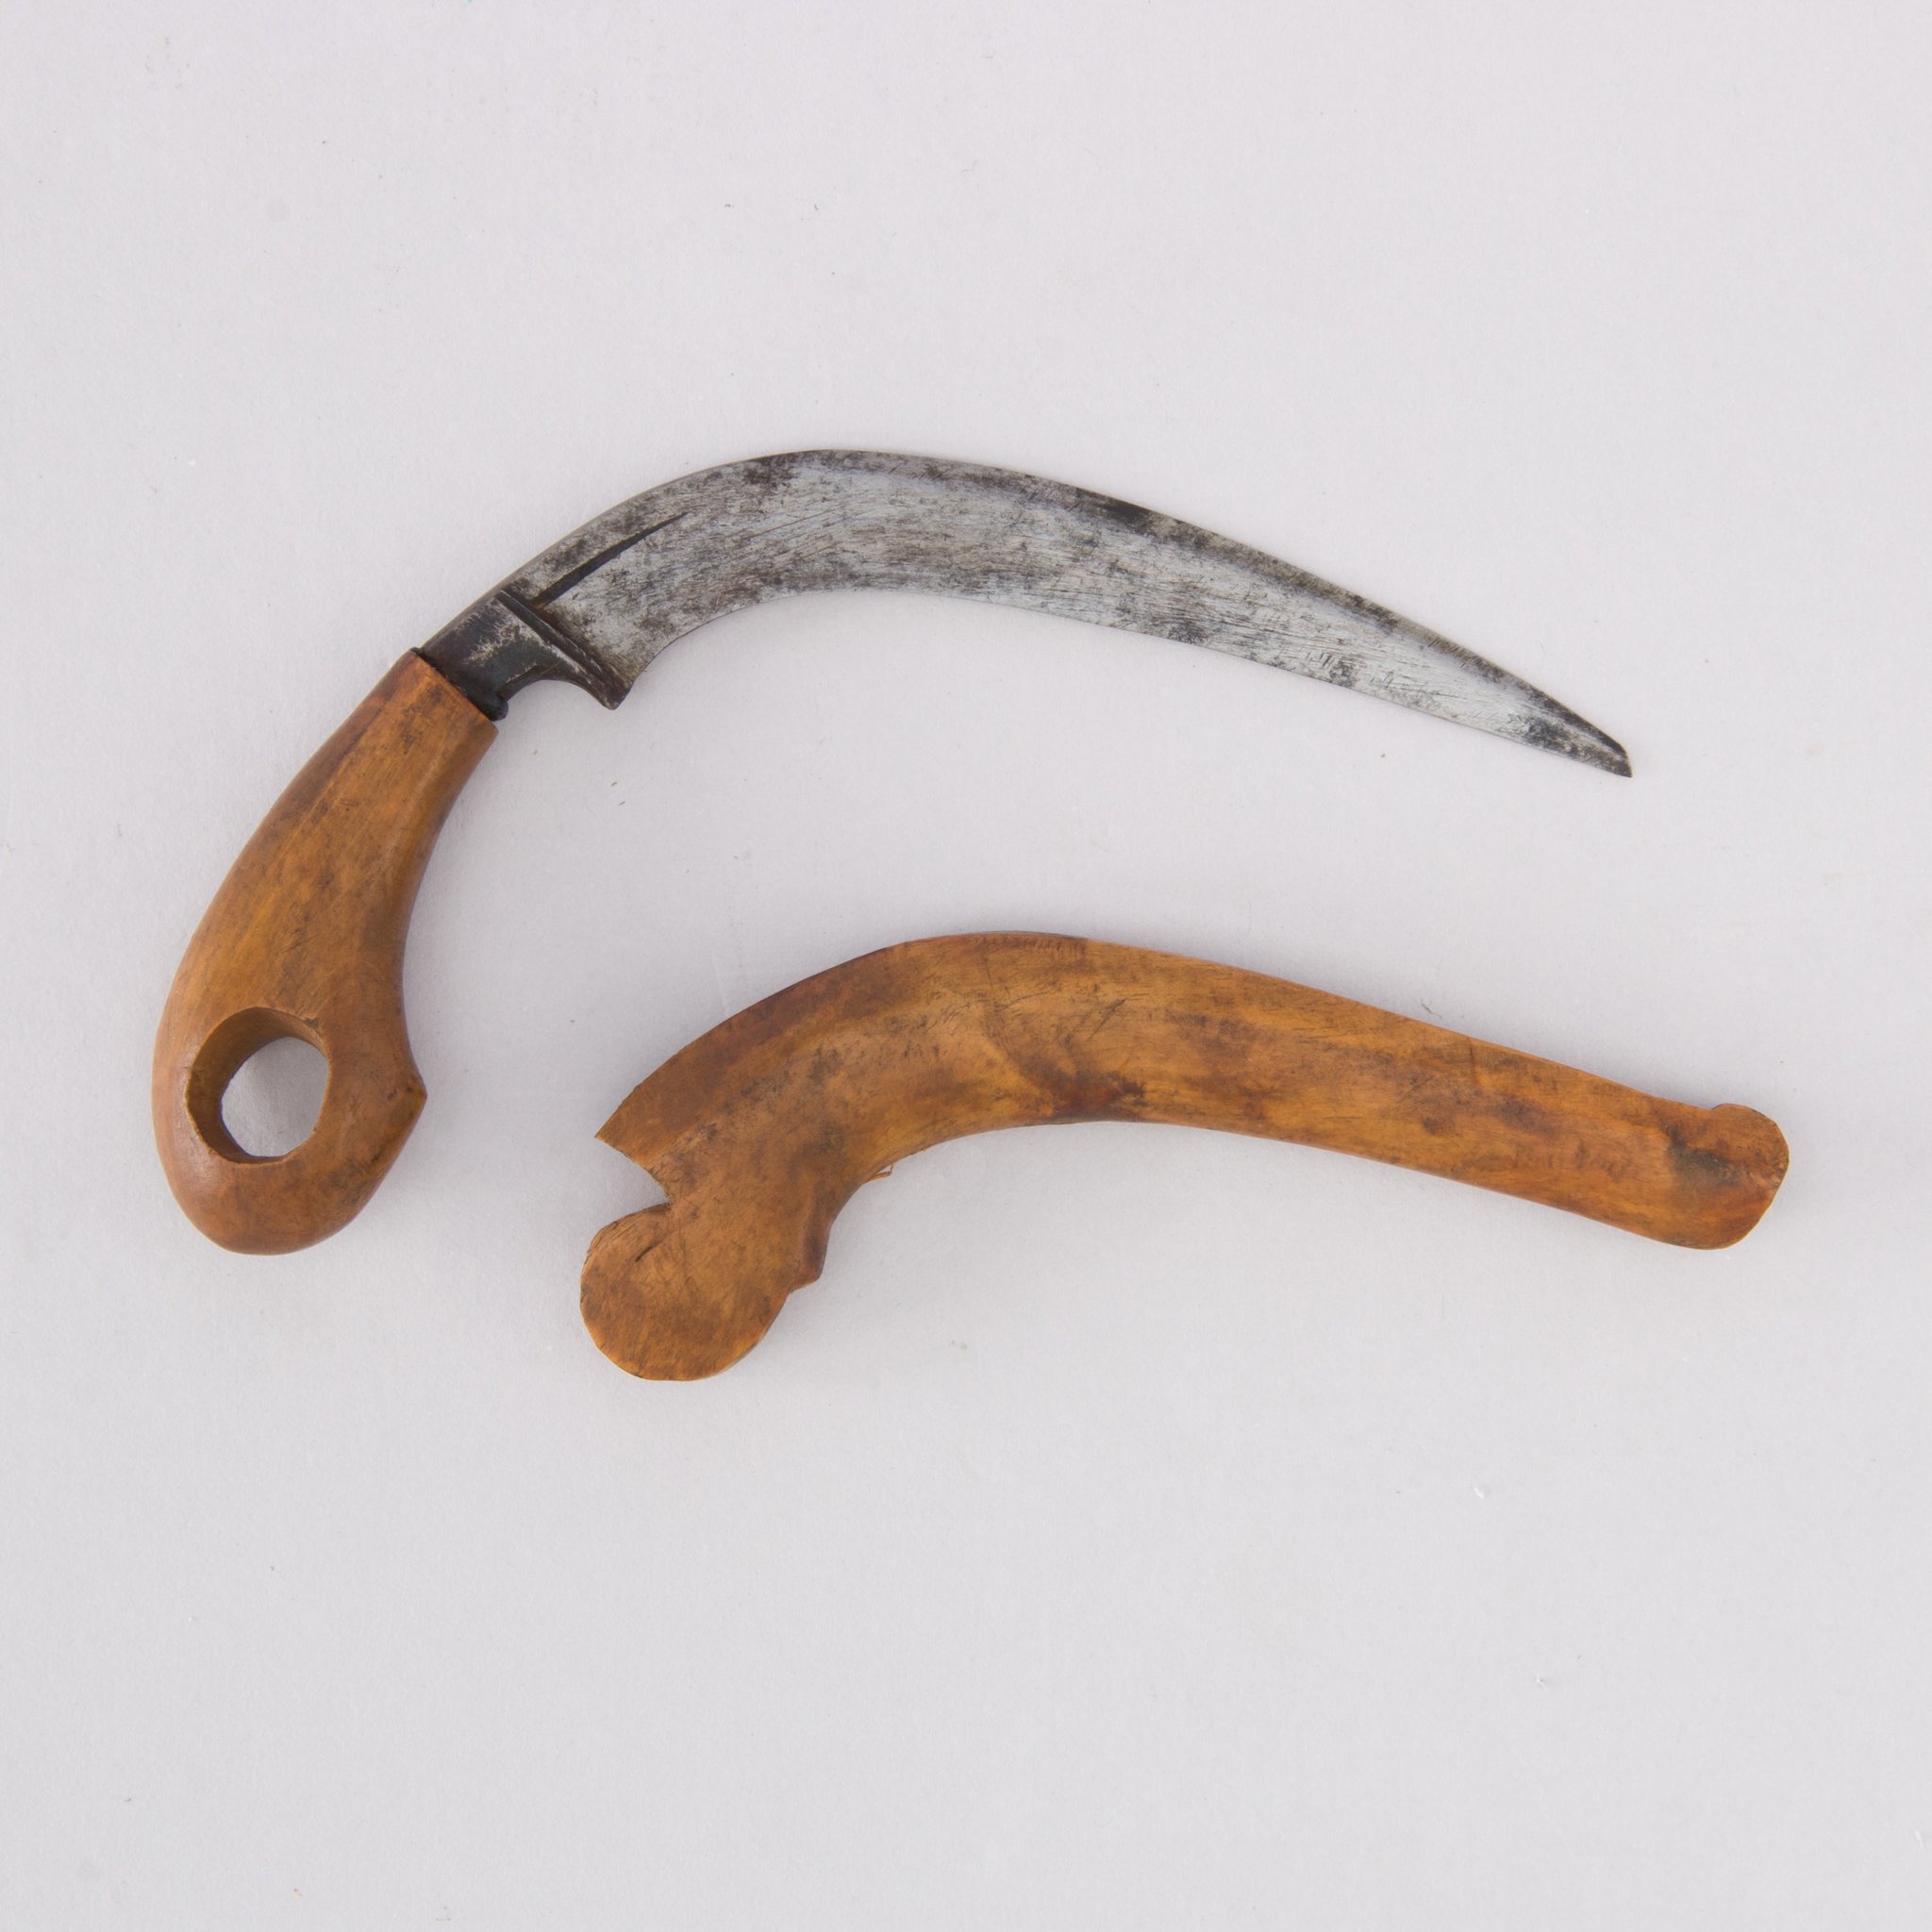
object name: knife korambi with sheath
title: Knife (Korambi) with Sheath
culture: indonesian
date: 1701-1900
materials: steel, wood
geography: indonesia